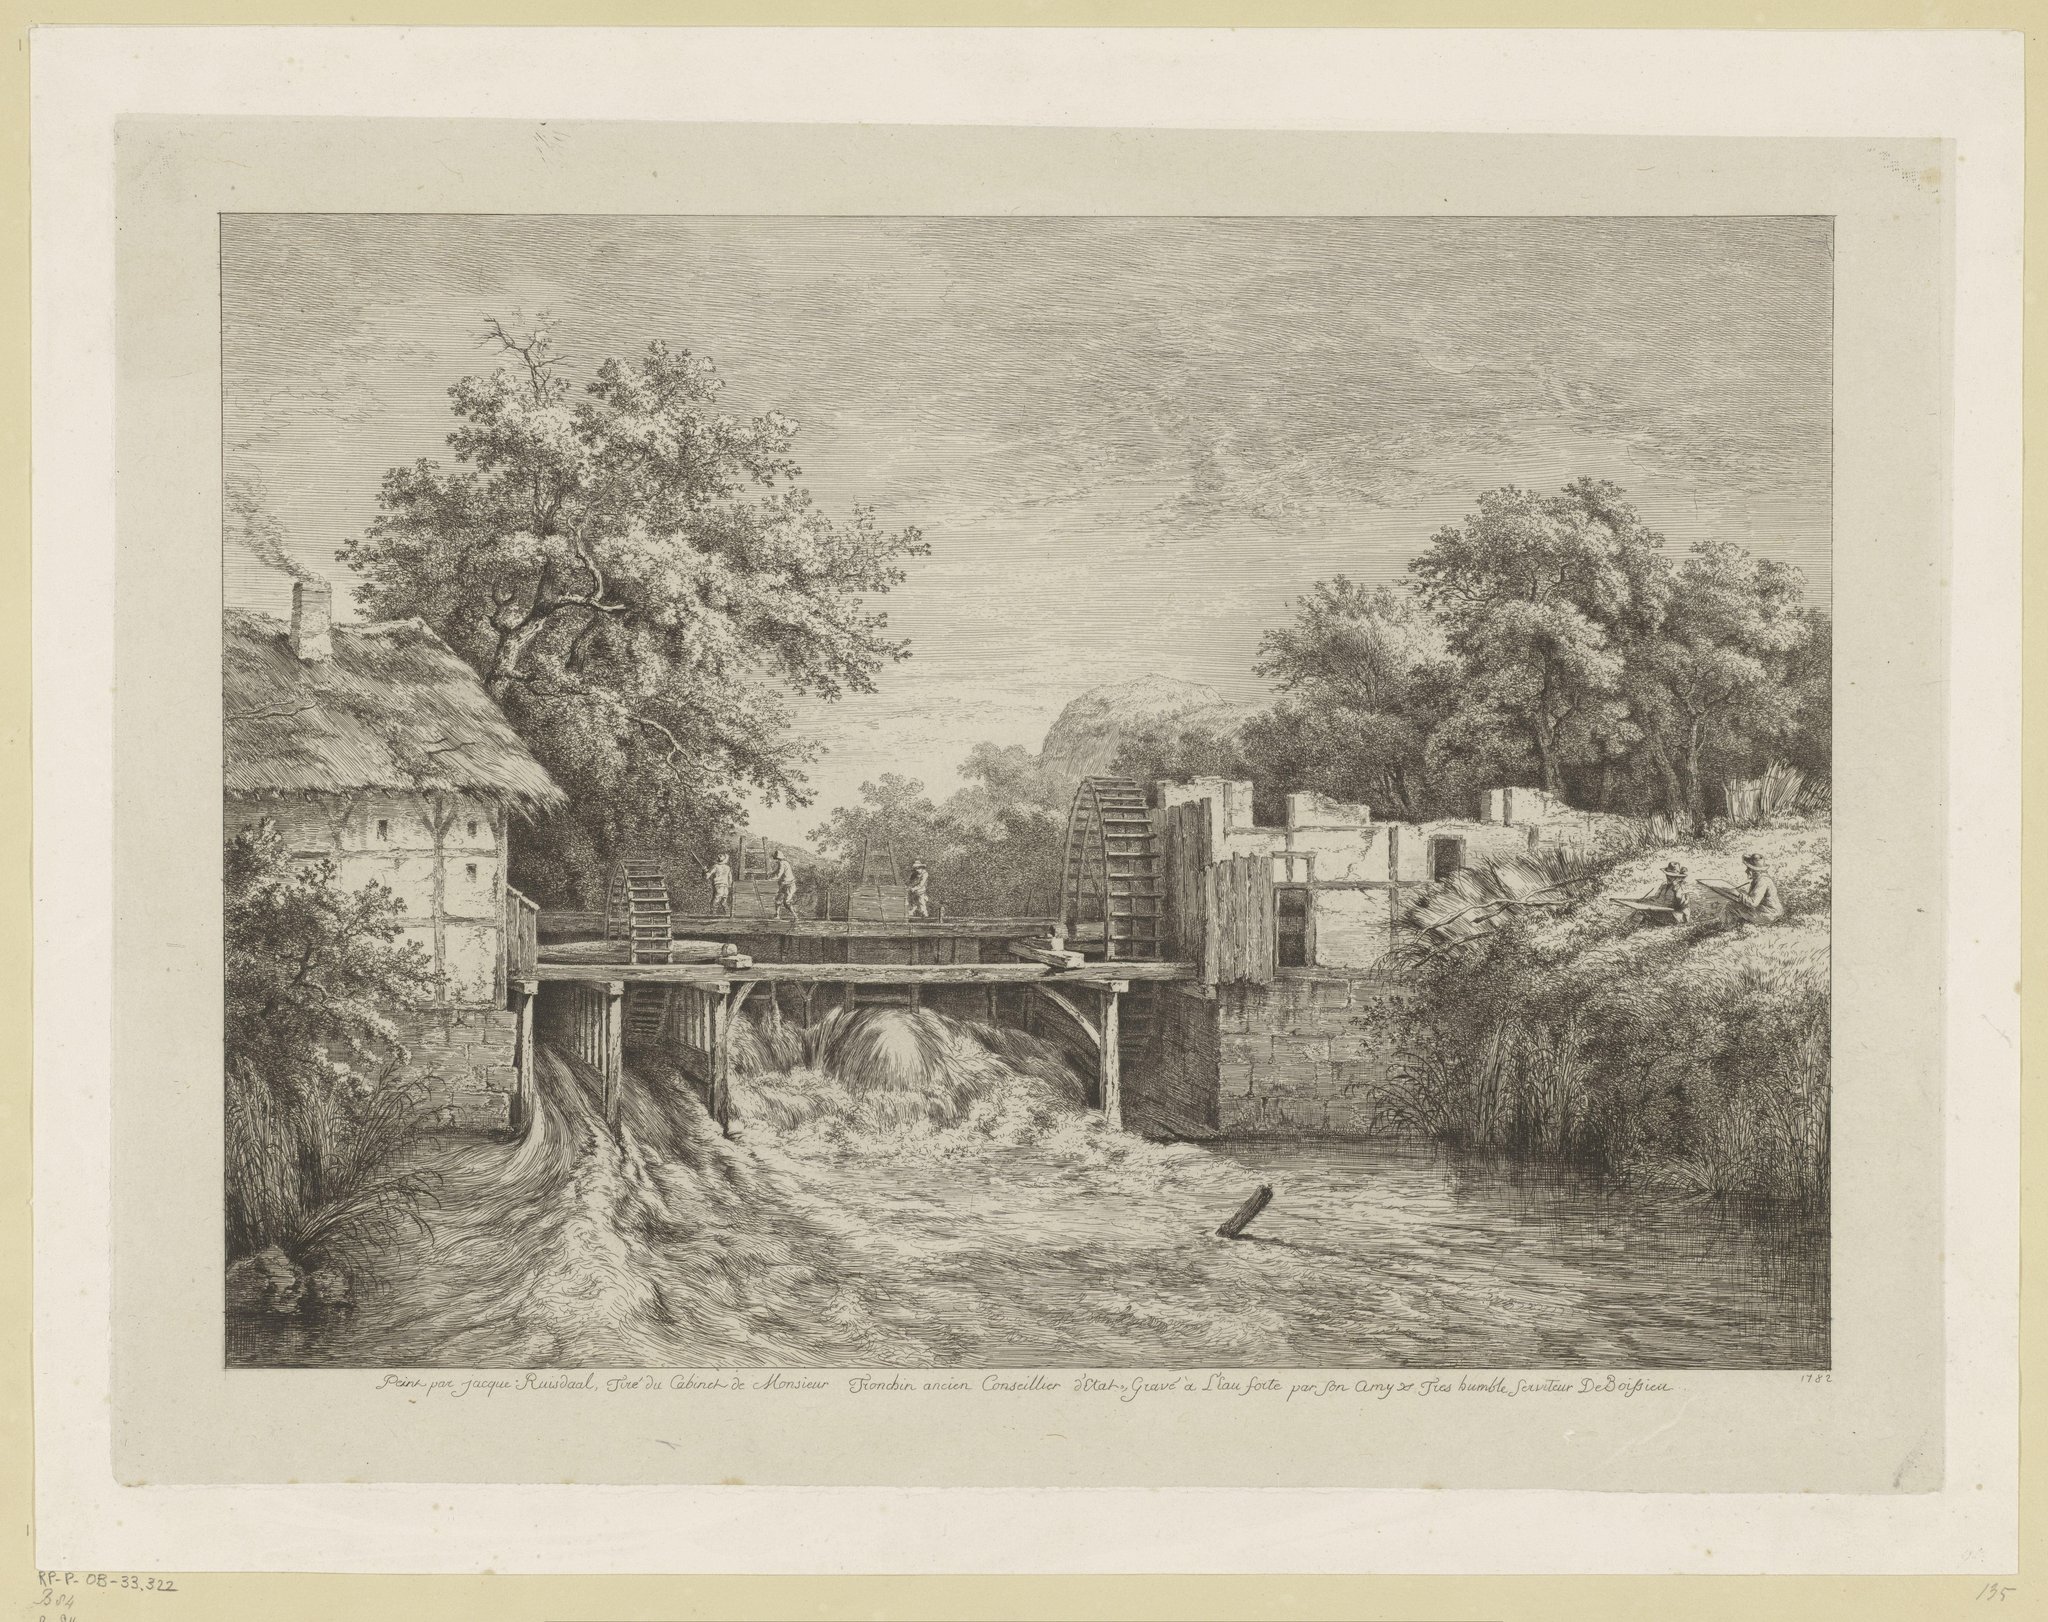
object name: print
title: Landschap met een watermolen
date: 1782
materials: paper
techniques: drypoint, etching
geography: france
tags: watermill in landscape, draughtsman at work - cc - out of doors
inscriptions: collector's mark: Lugt 12